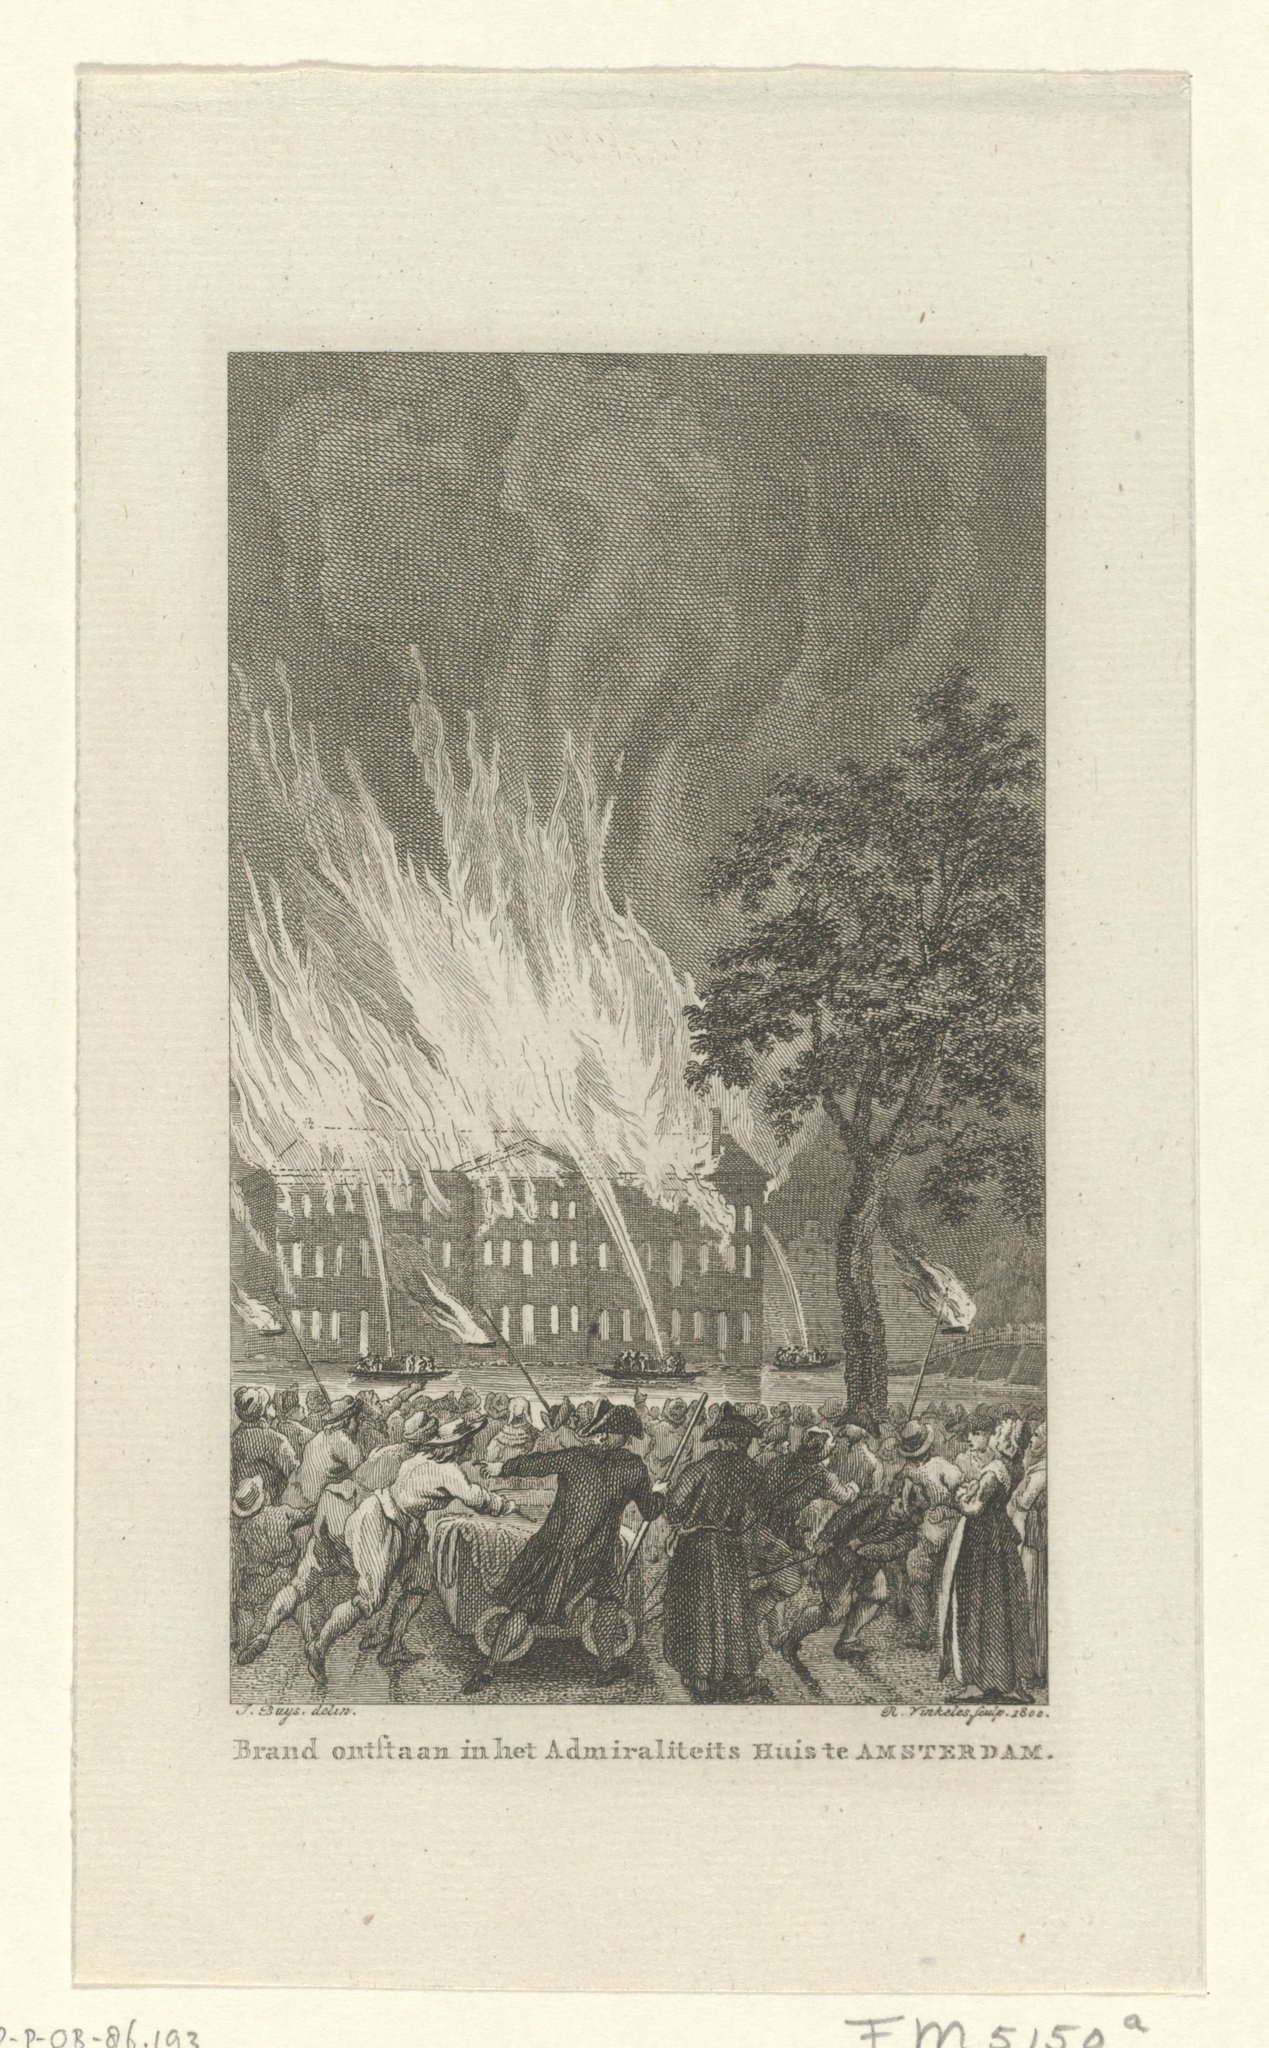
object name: print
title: Brand in 's Lands Zeemagazijn, 1791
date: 1800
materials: paper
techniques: engraving, etching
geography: northern netherlands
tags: on fire, ablaze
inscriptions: collector's mark: Lugt 2228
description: Gebruikt als illustratie in: P.A. Loosjes. Vaderlandsche historie, vervattende de geschiedenissen, der Vereenigde Nederlanden (...). Ten onmiddelyken vervolge van Wagenaar's Vaderlandsche historie. Amsterdam: Johannes Allart, dl. 24 (1800).